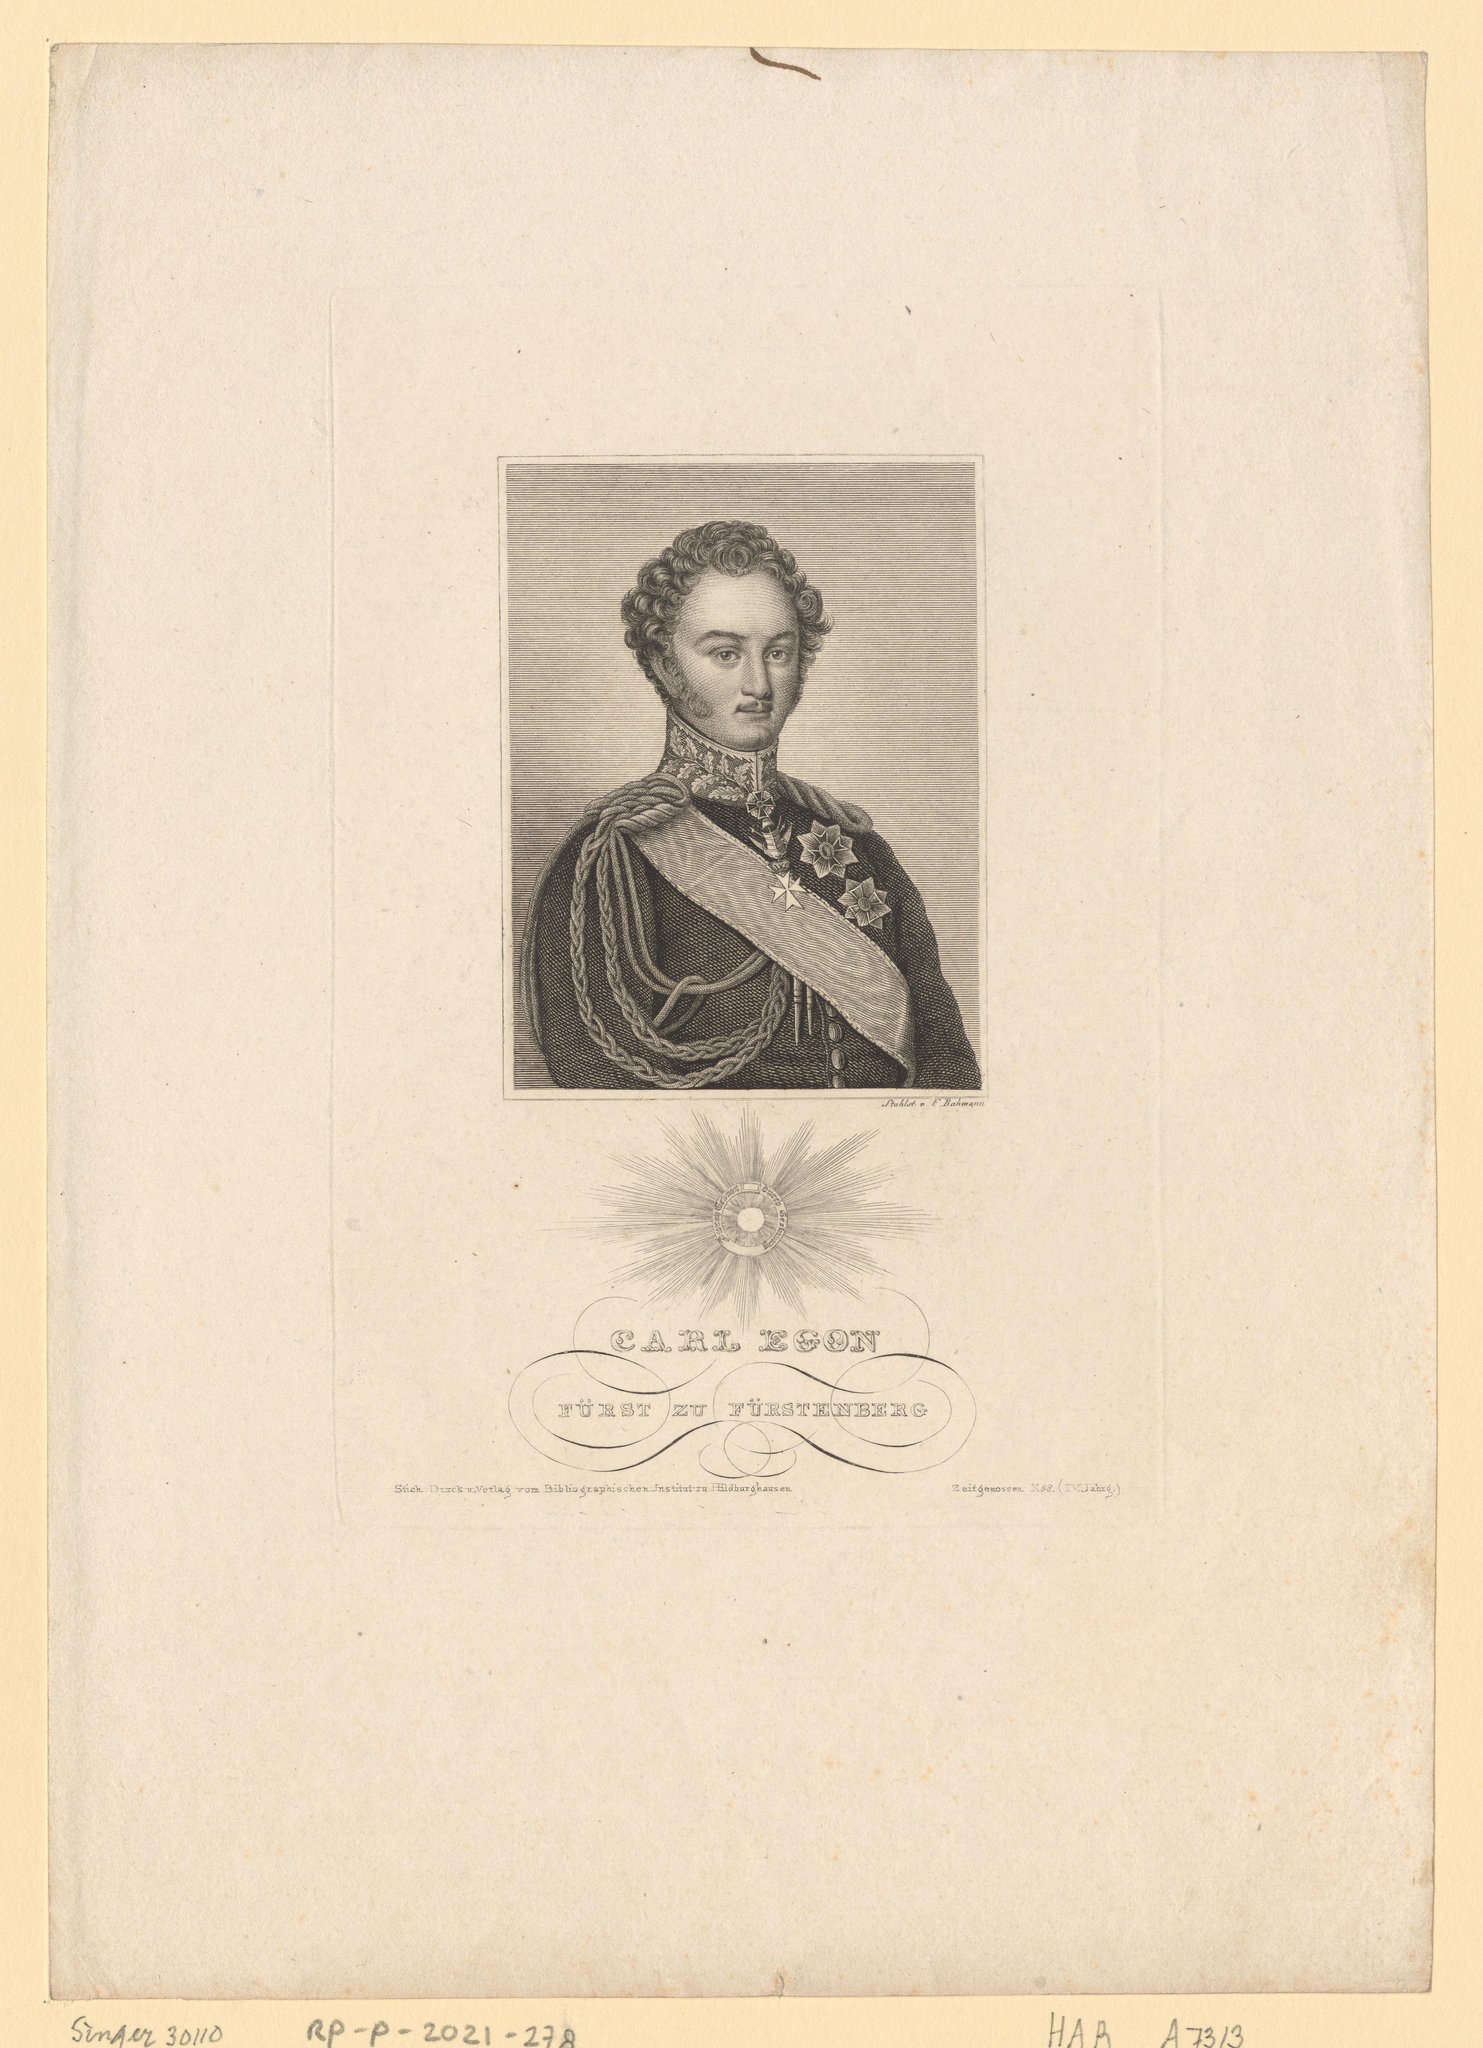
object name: print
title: Zeitgenossen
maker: ferdinand bahmann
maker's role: print maker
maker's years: 1800-1883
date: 1833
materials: paper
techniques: engraving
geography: germany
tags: prague, politician, historical persons, politician, e.g. party leader, (military) uniforms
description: De serie werd uitgegeven tussen 1829 en ca. 1840.